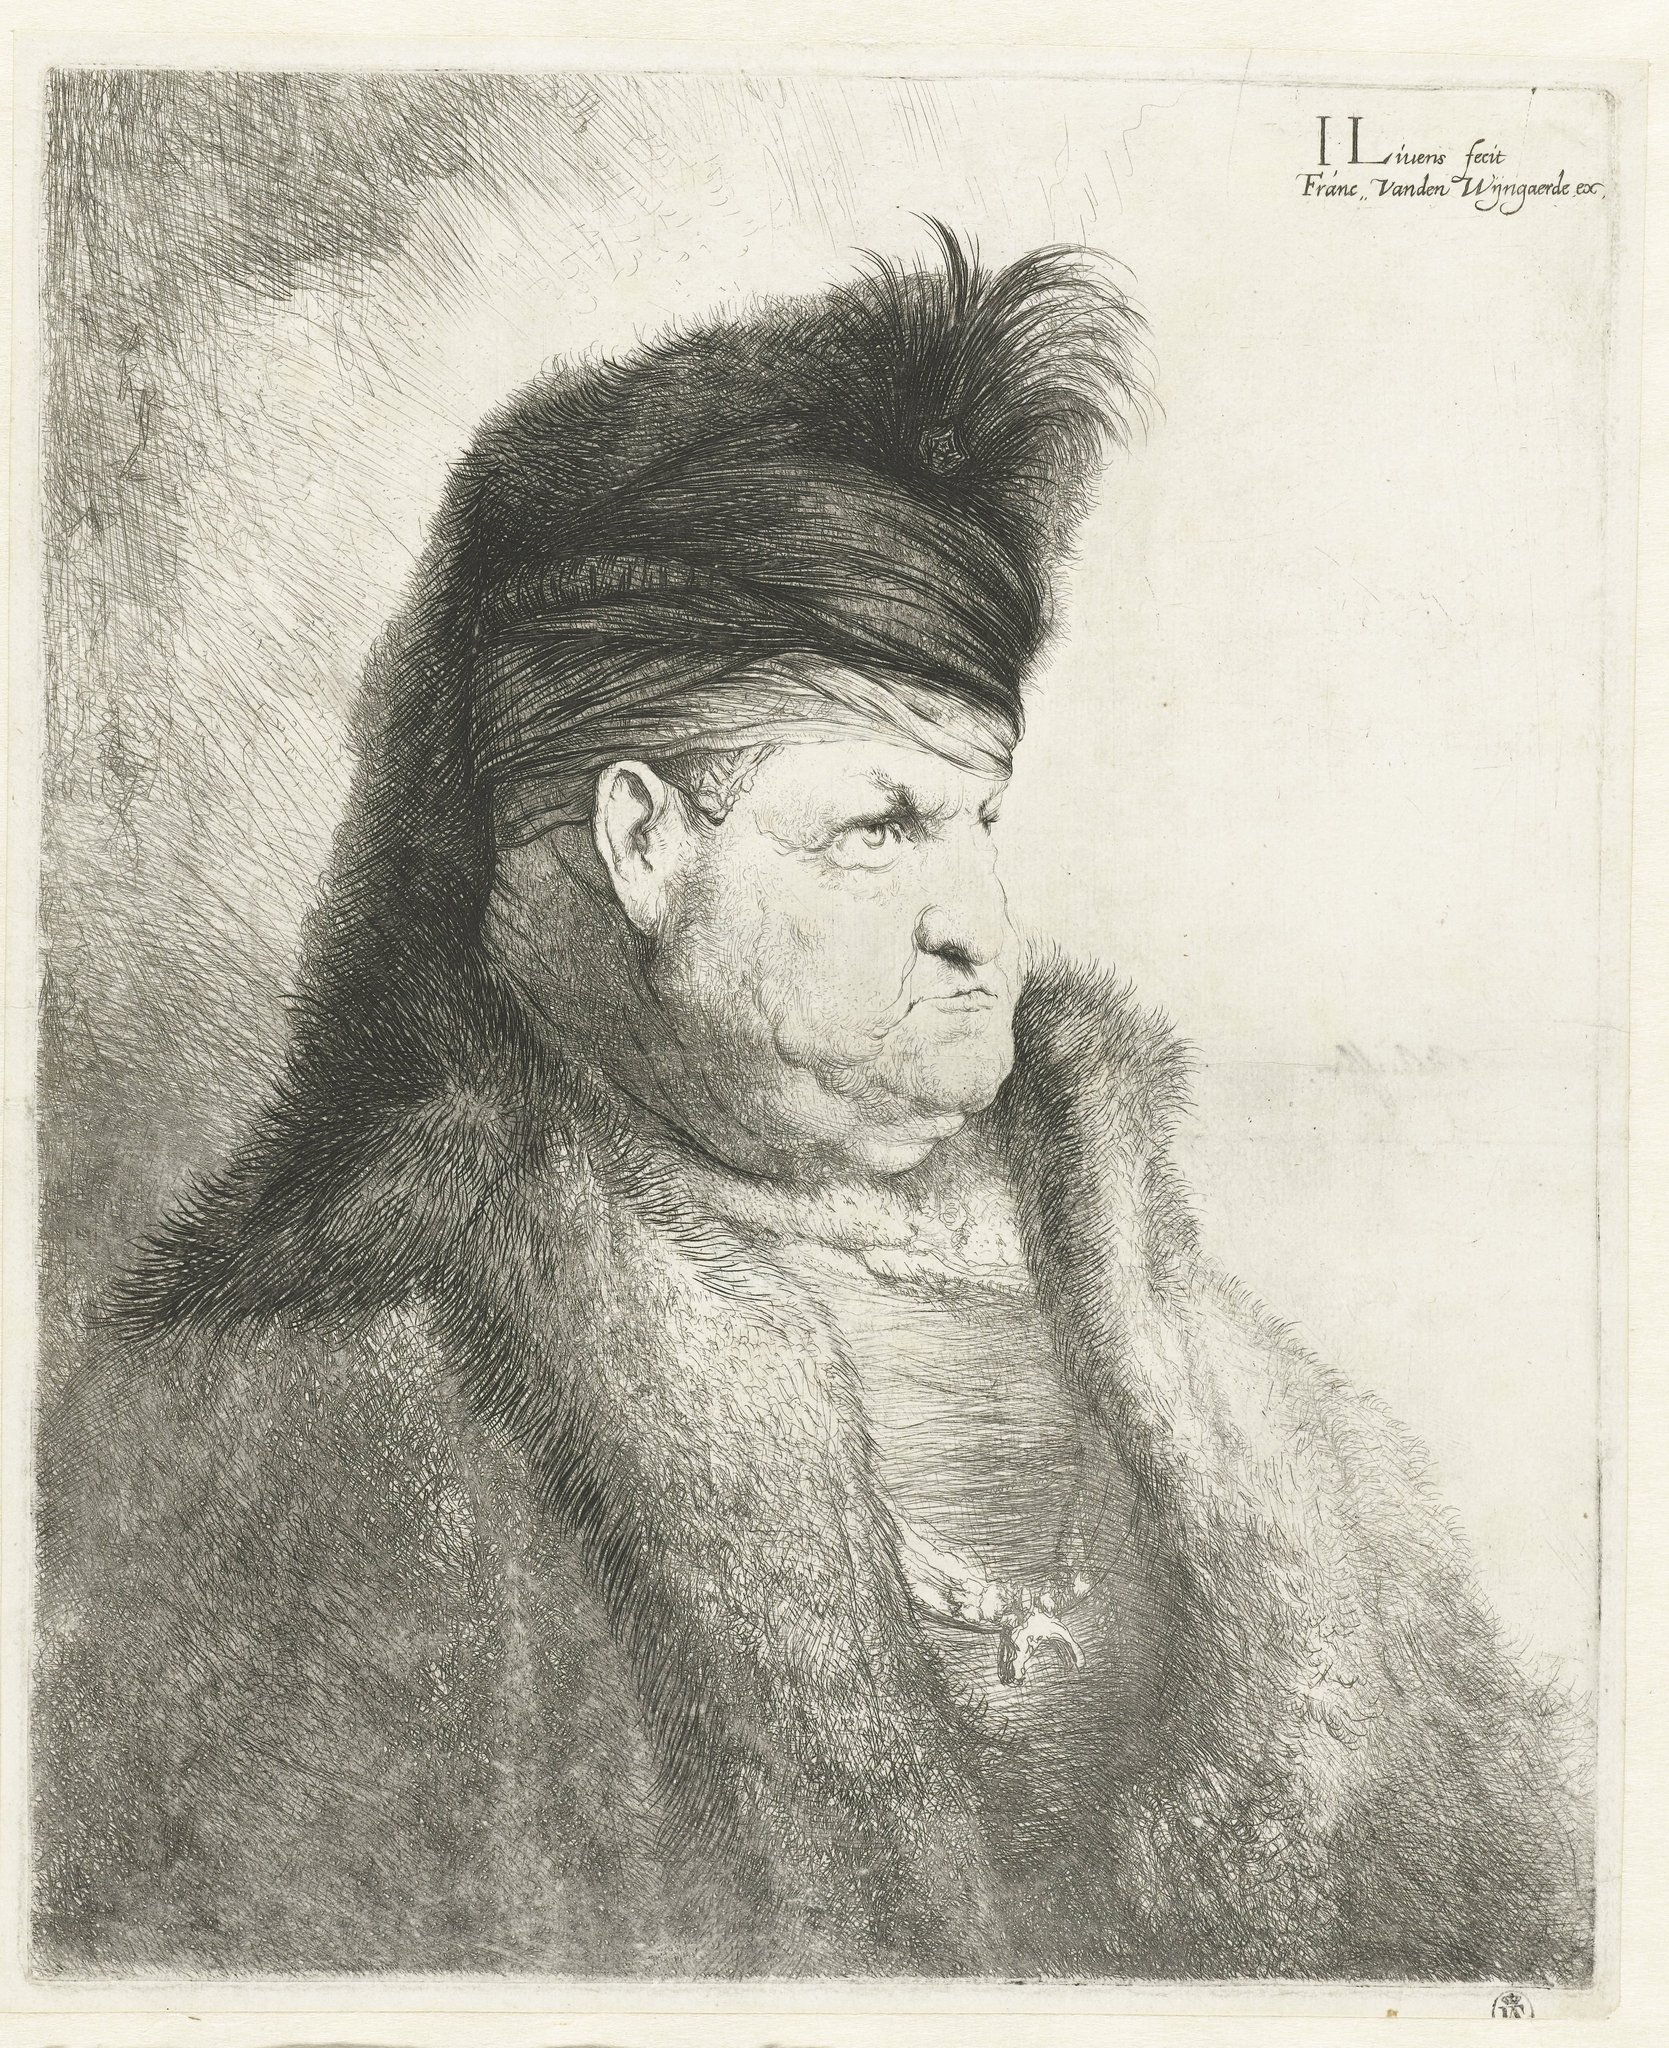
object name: print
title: Borstbeeld van een oosterling met tulband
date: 1625-1632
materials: paper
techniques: engraving, etching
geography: leiden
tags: head-gear: turban, human races; peoples; nationalities (+ costume), fashion, clothing (+ fur used for clothes), male sex; man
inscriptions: collector's mark: Lugt 971, collector's mark: Lugt 2228, collector's mark: Lugt 2166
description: Bij Hollstein wordt een staat niet vermeld, er zijn vier staten van deze prent bekend (Schatborn 1988)